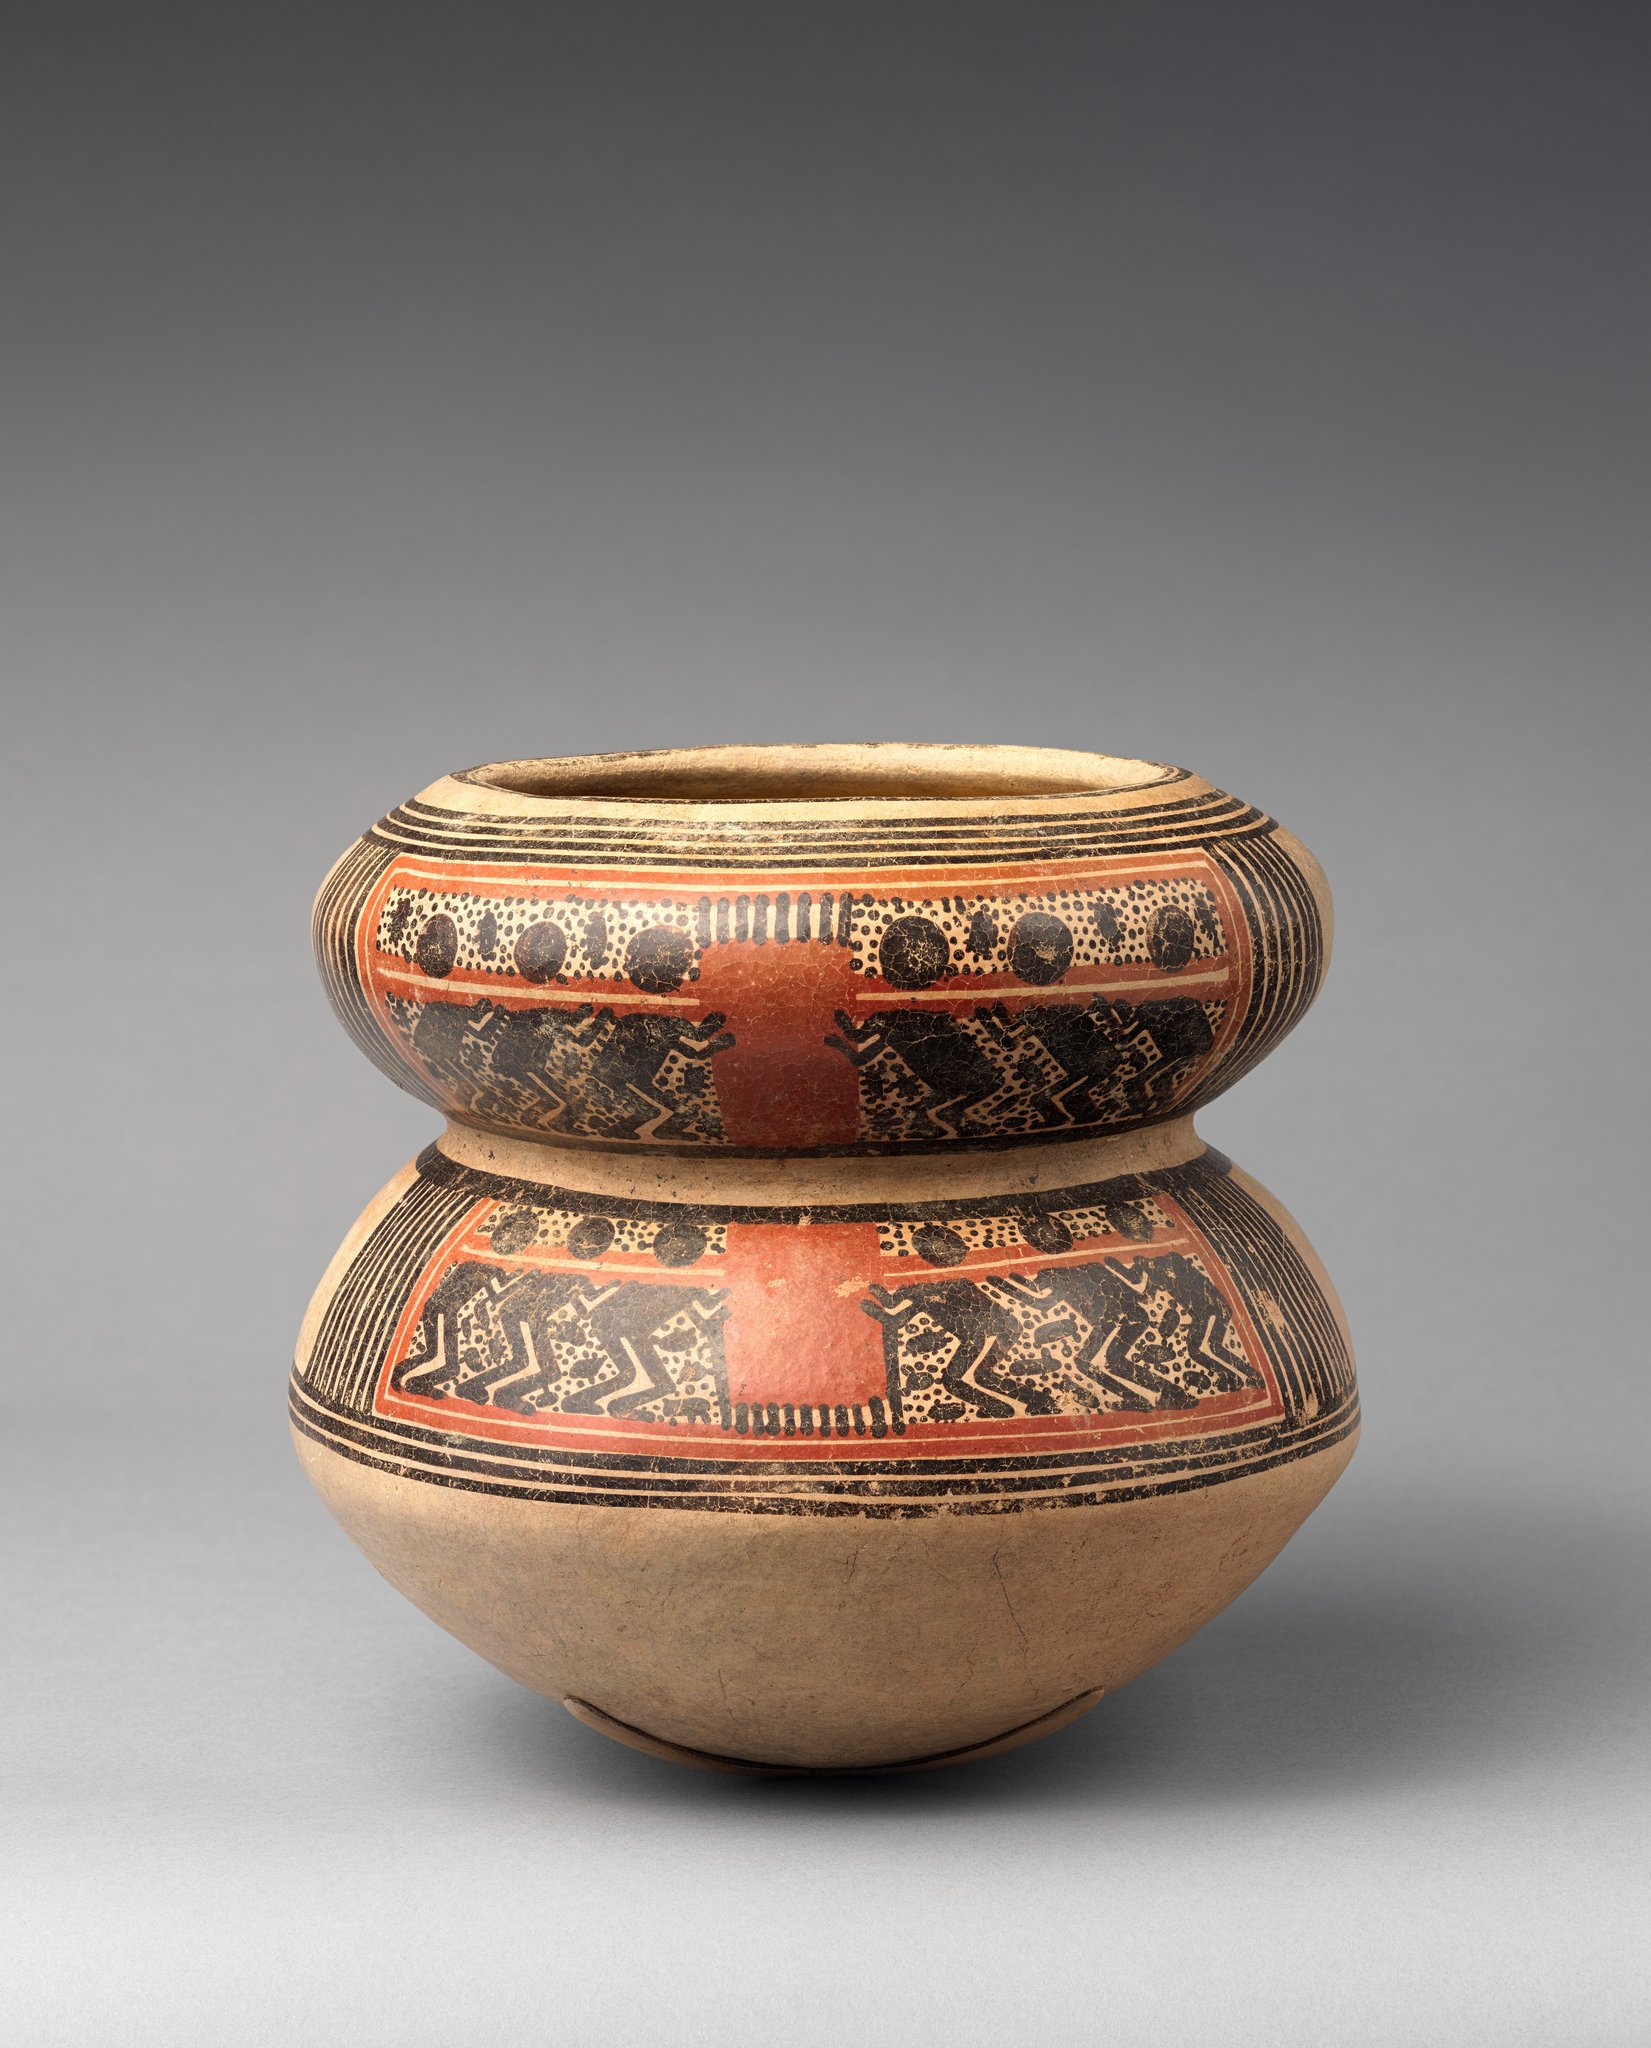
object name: jar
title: Double-Tiered Jar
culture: tonosí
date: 201-400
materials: ceramic, pigment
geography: panama